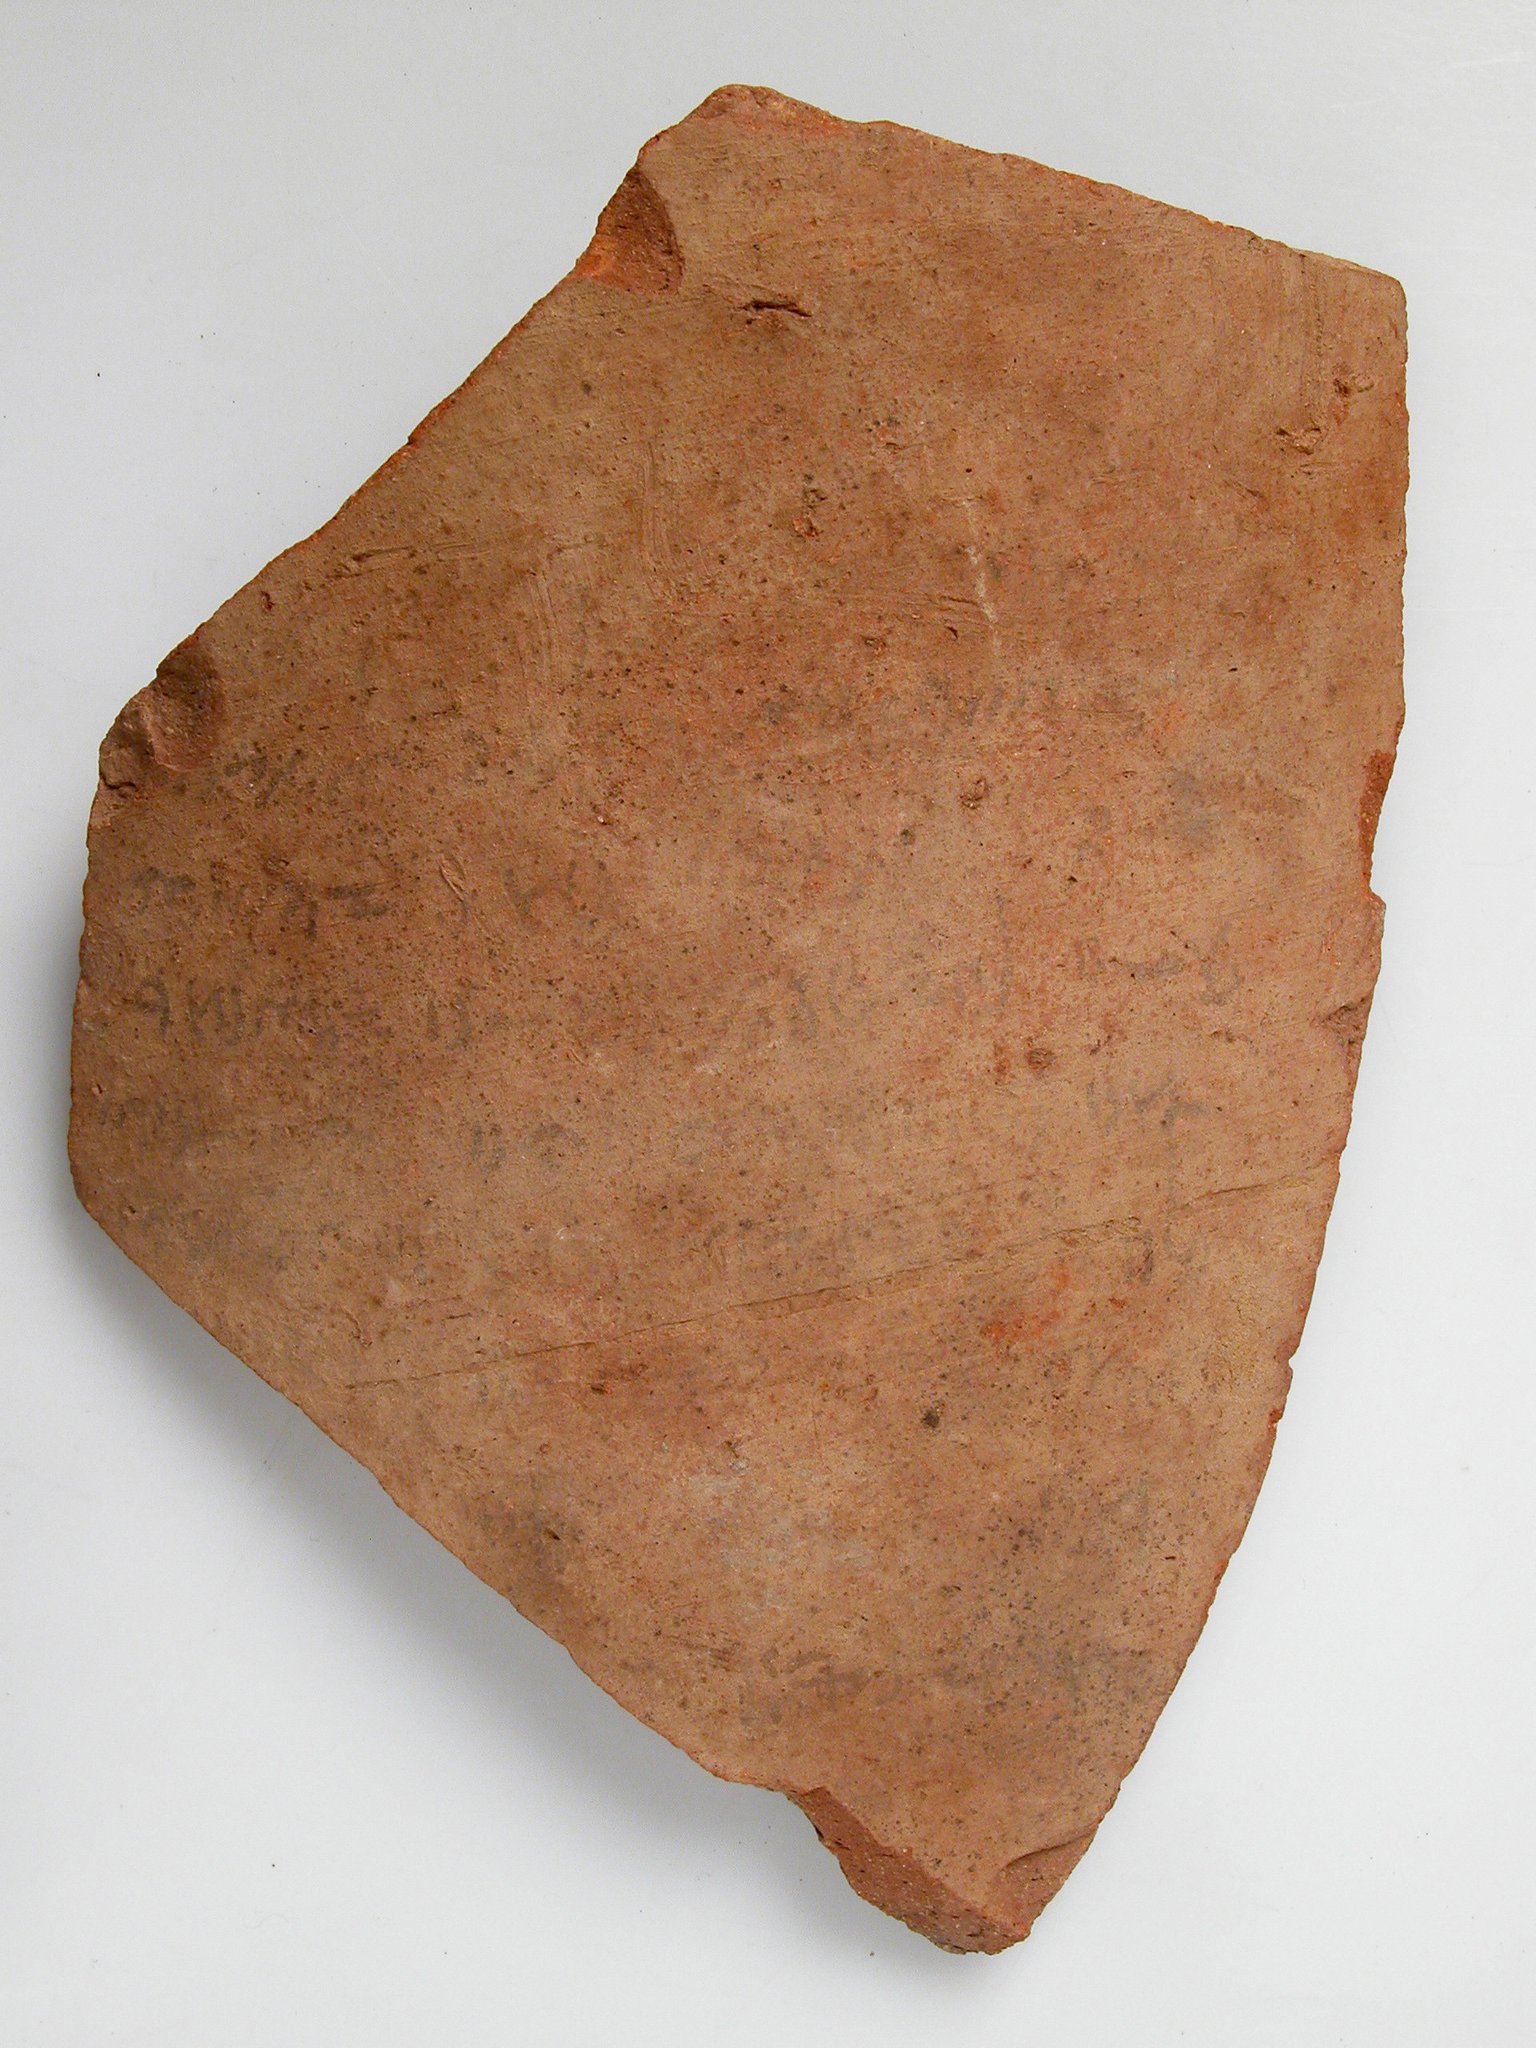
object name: ostracon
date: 400-30 BCE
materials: ink, pottery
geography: egypt